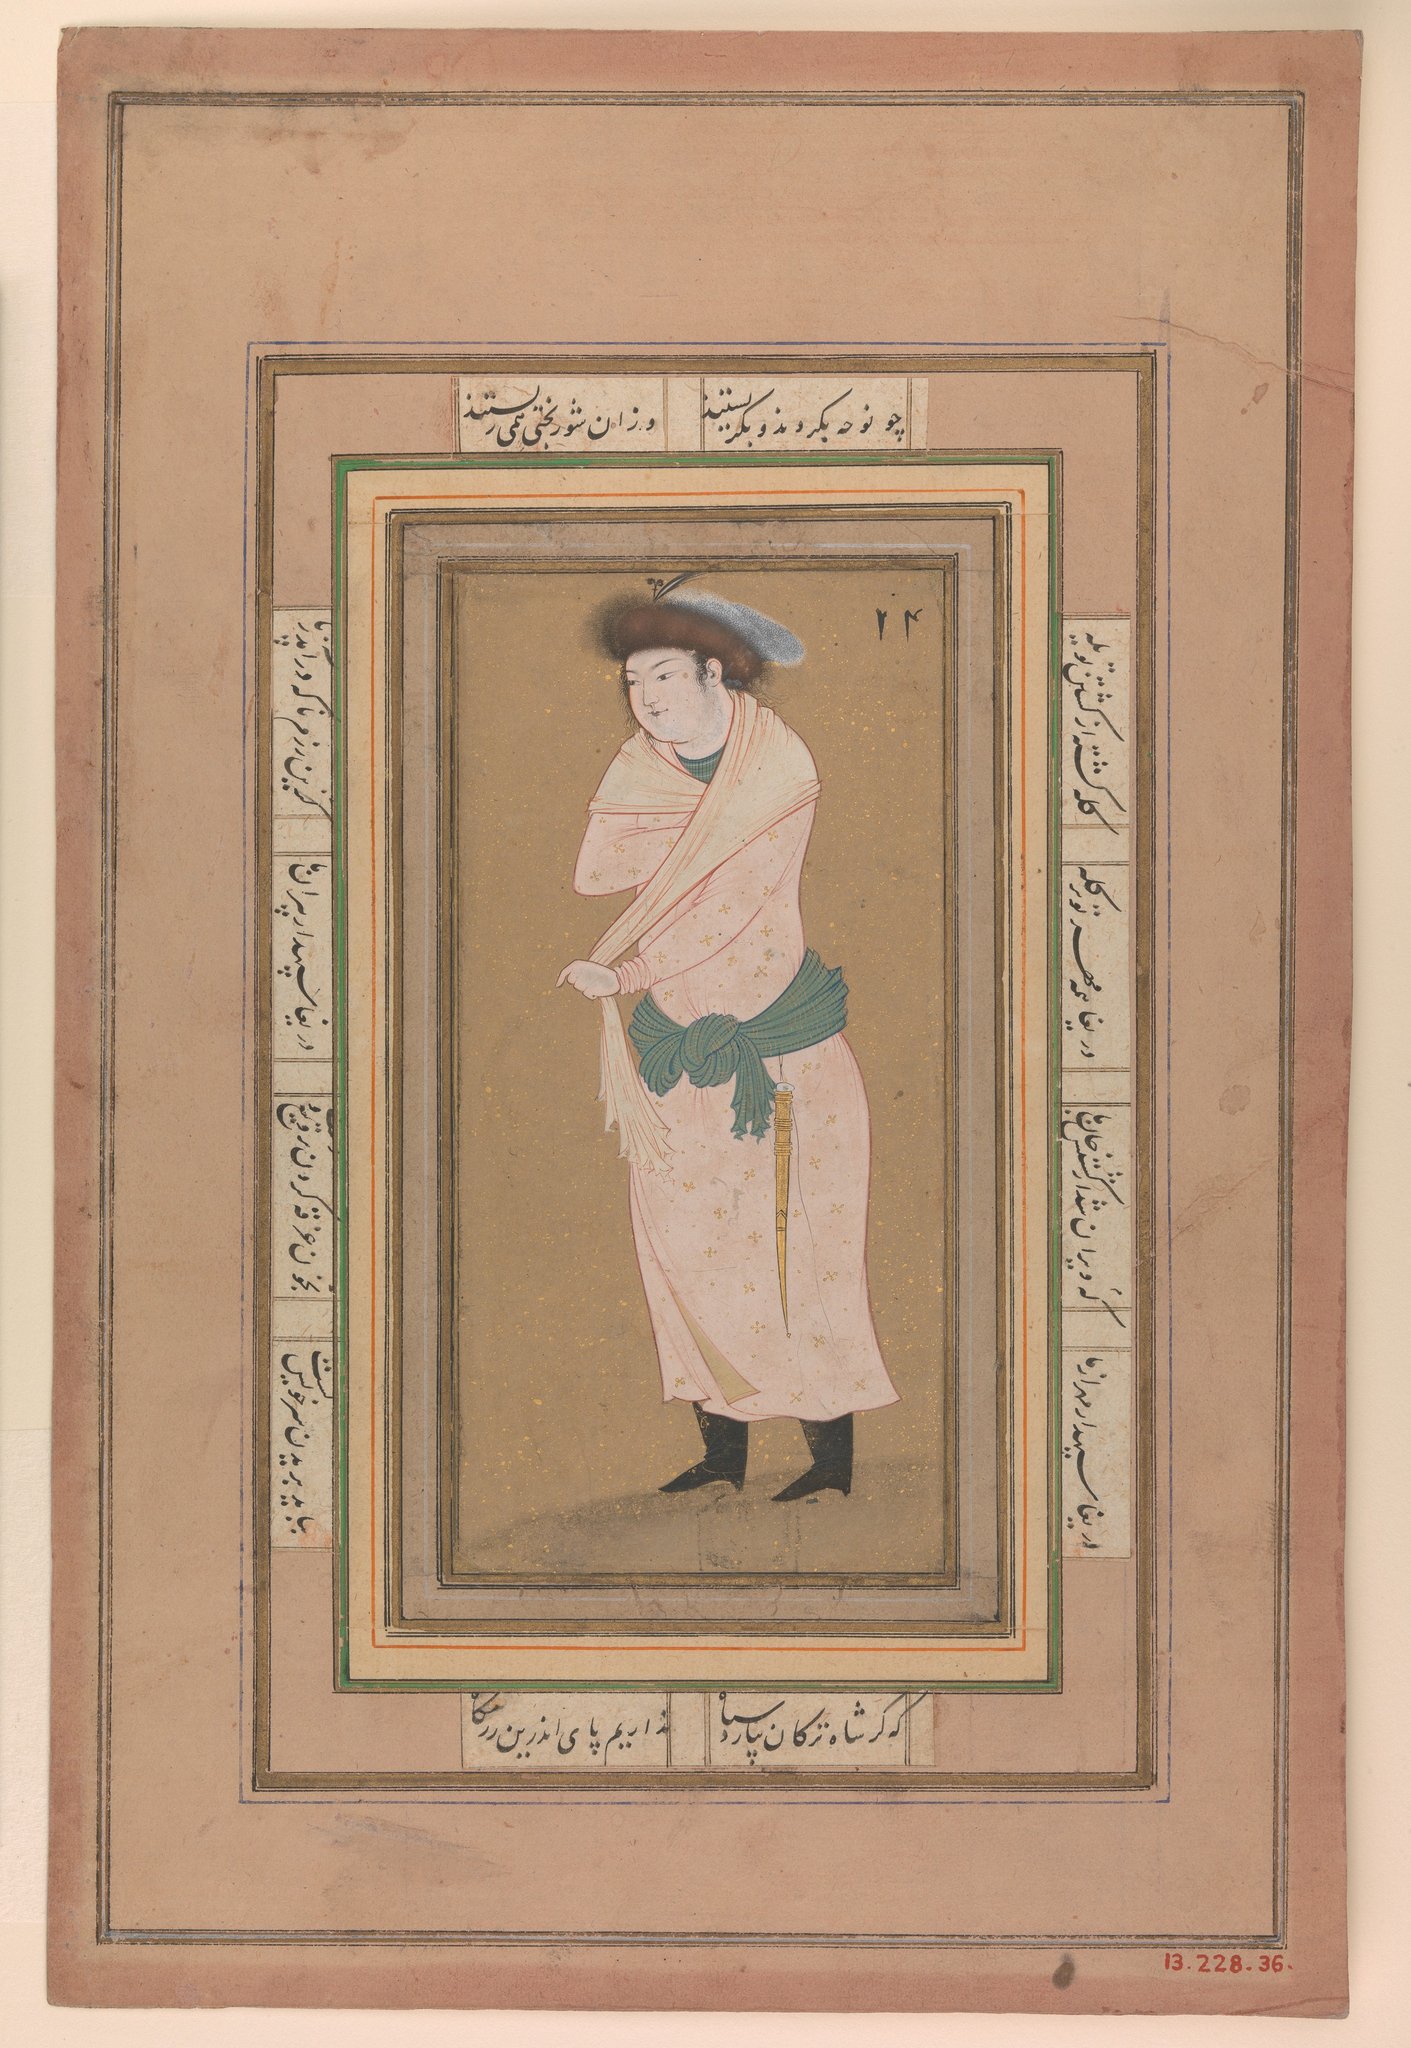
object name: illustrated single work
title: Portrait of a Man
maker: riza-yi 'abbasi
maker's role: artist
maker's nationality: iranian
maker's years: 1540-1660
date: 1600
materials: gold, ink, paper, watercolor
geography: iran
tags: men,portraits